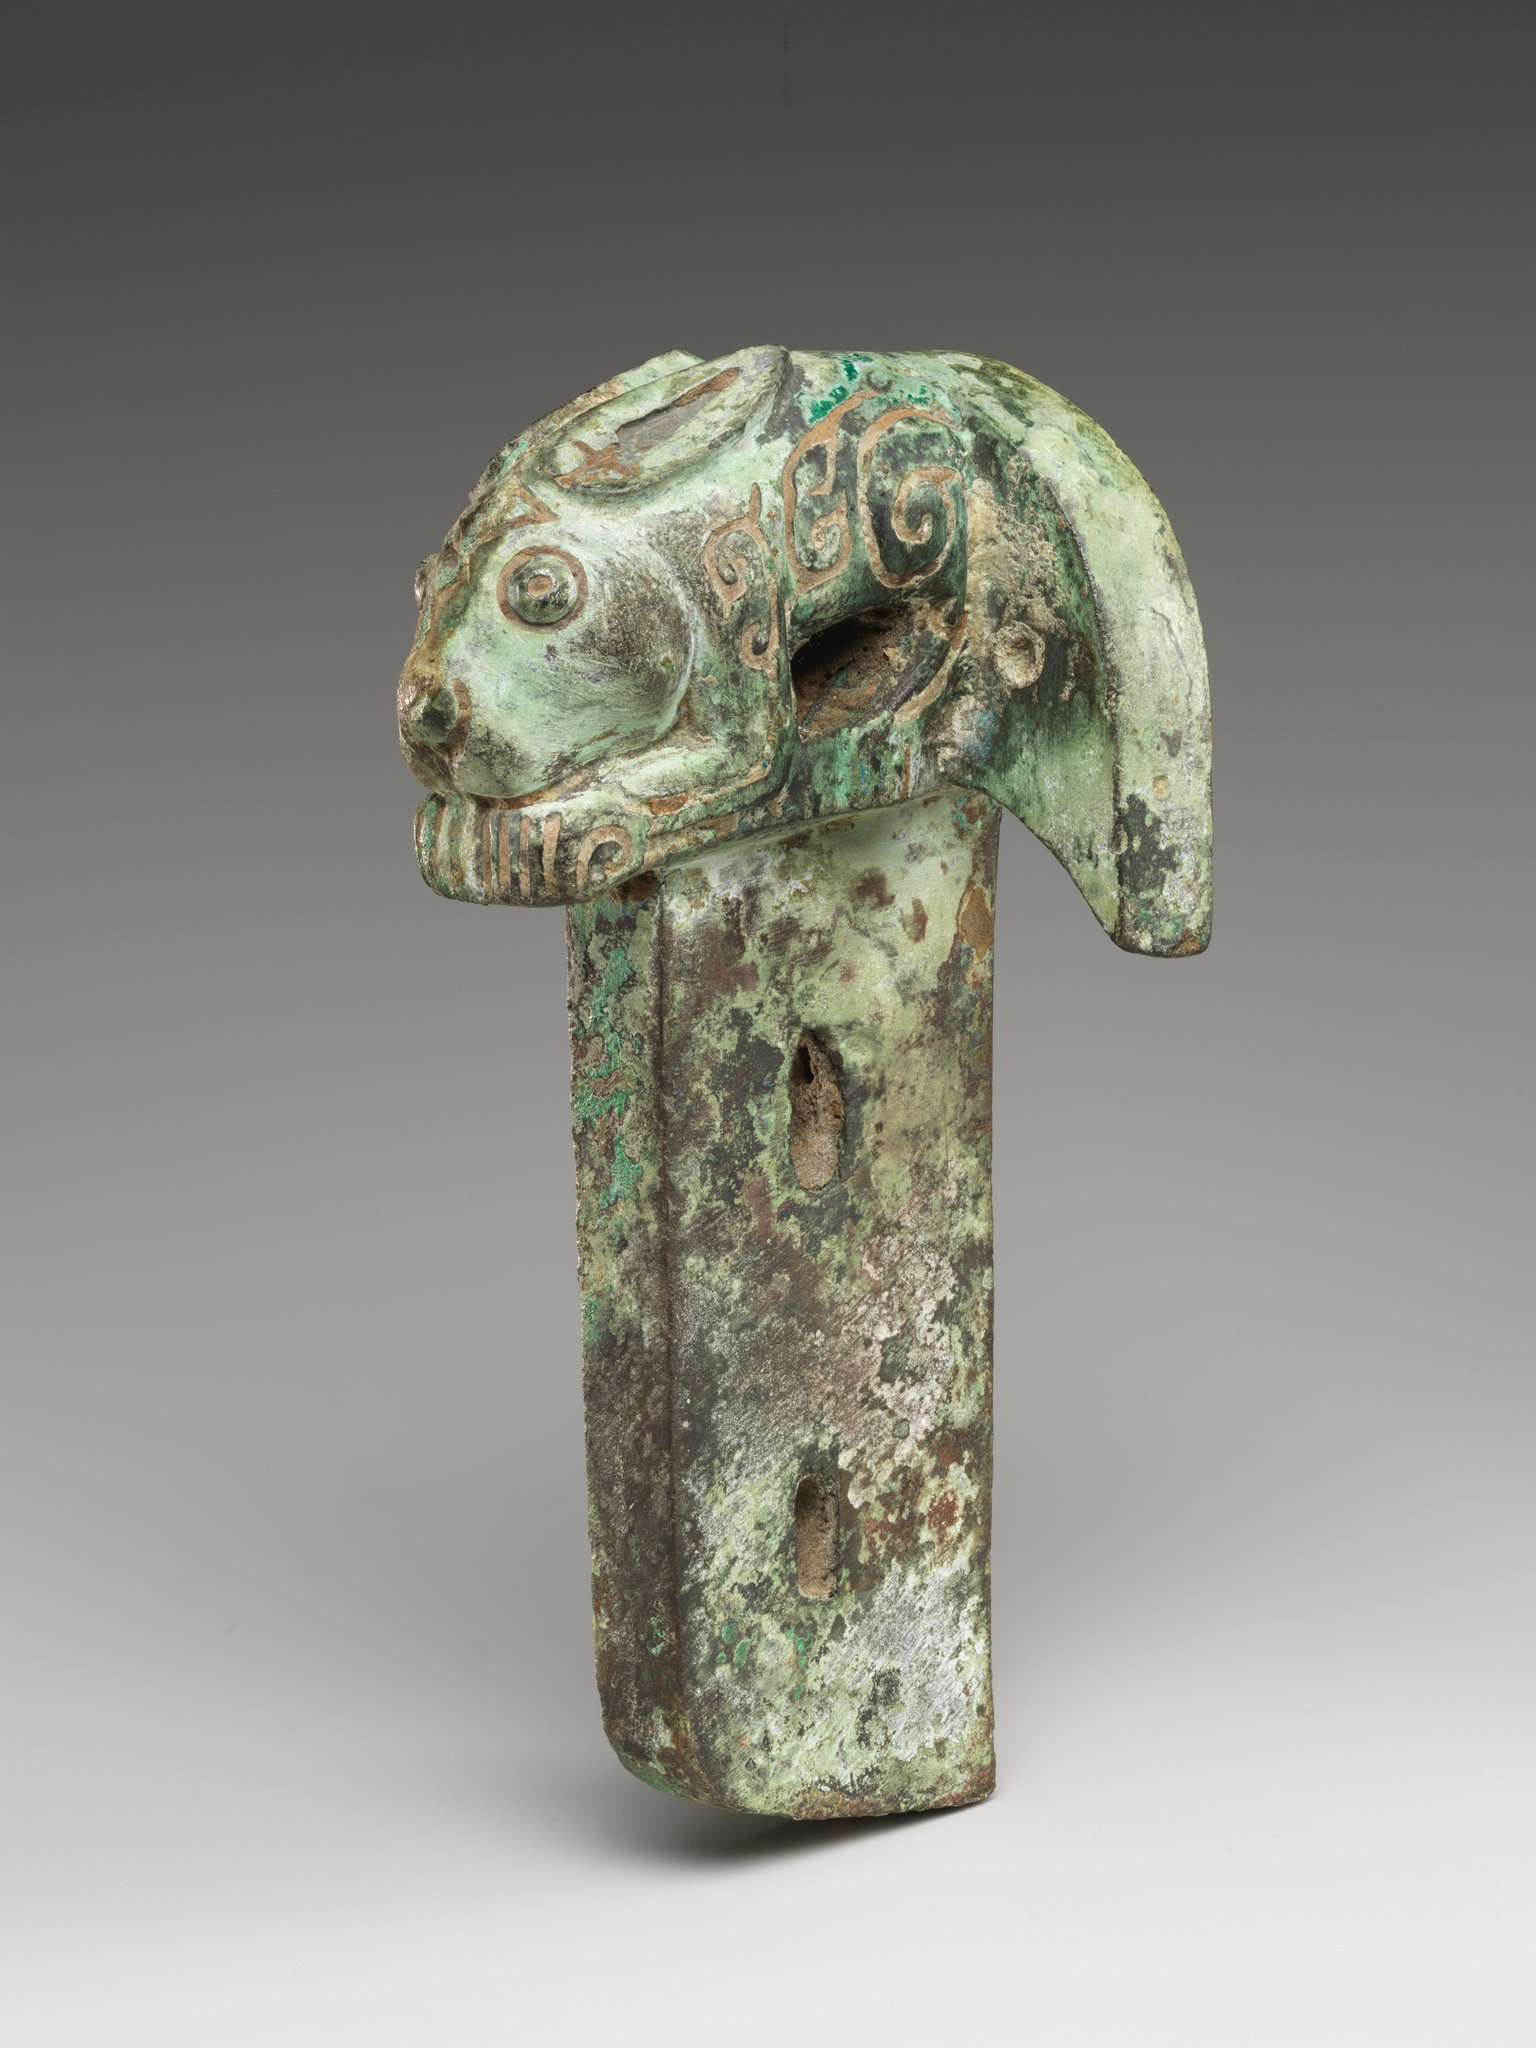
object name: chariot linchpin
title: Chariot linchpin with rabbit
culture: chinese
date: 1100-801 BCE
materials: bronze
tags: rabbits